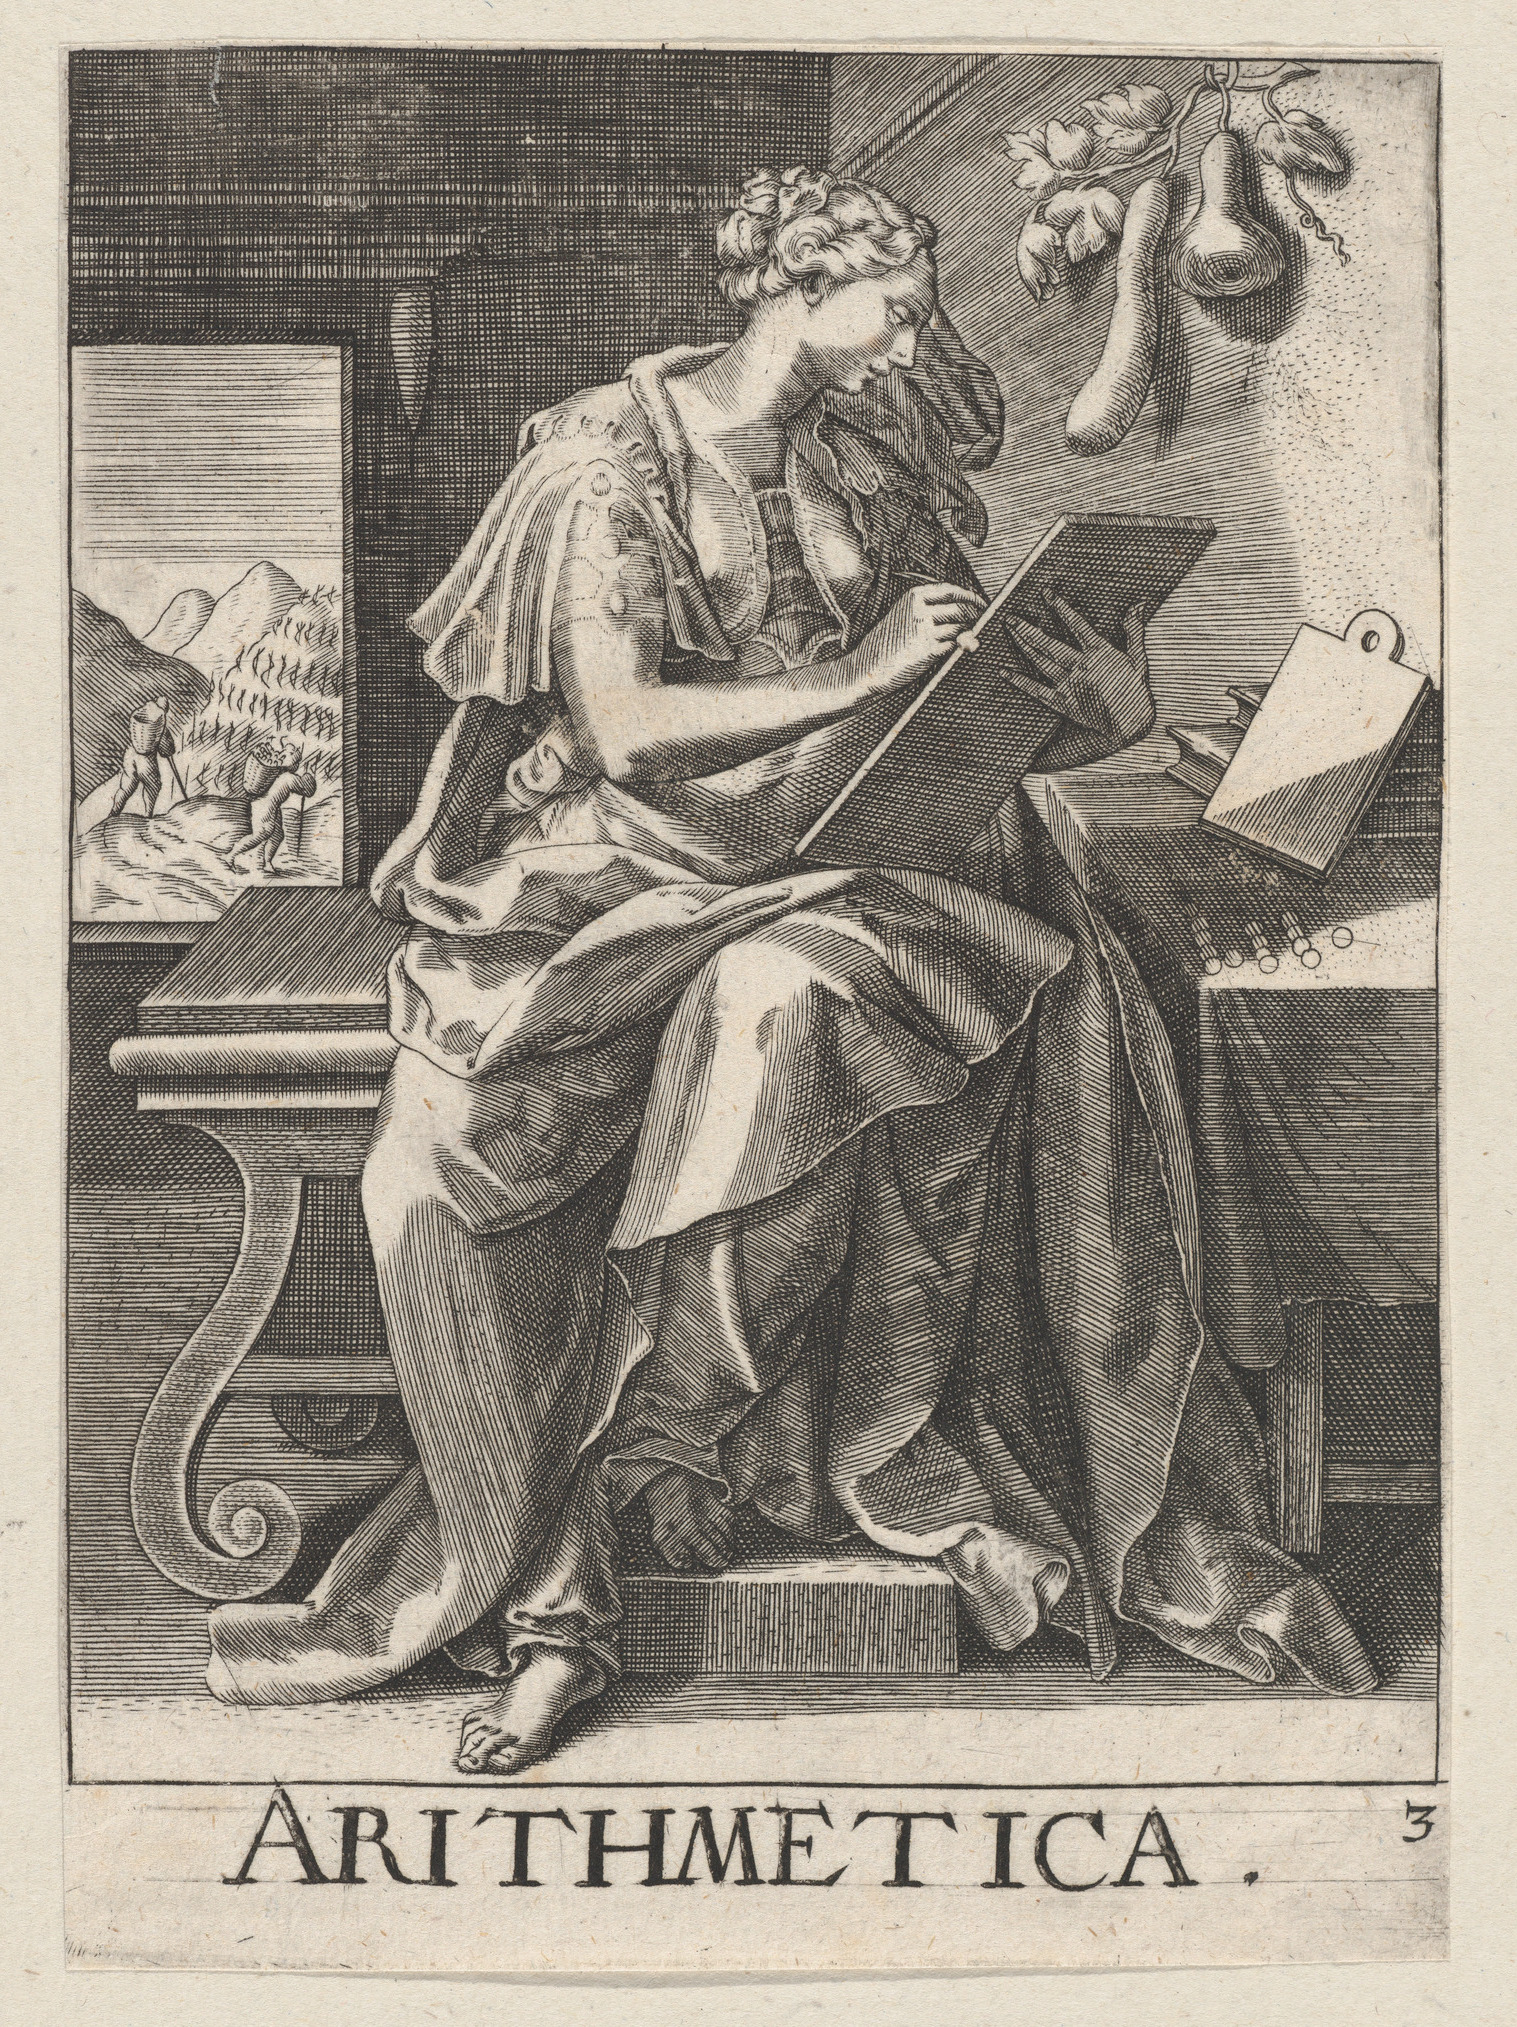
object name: print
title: Arithmetica, from "The Seven Liberal Arts"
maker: johann sadeler (i)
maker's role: artist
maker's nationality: netherlandish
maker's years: 1550-1601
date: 1570-1600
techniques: engraving, etching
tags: women,mathematics,writing